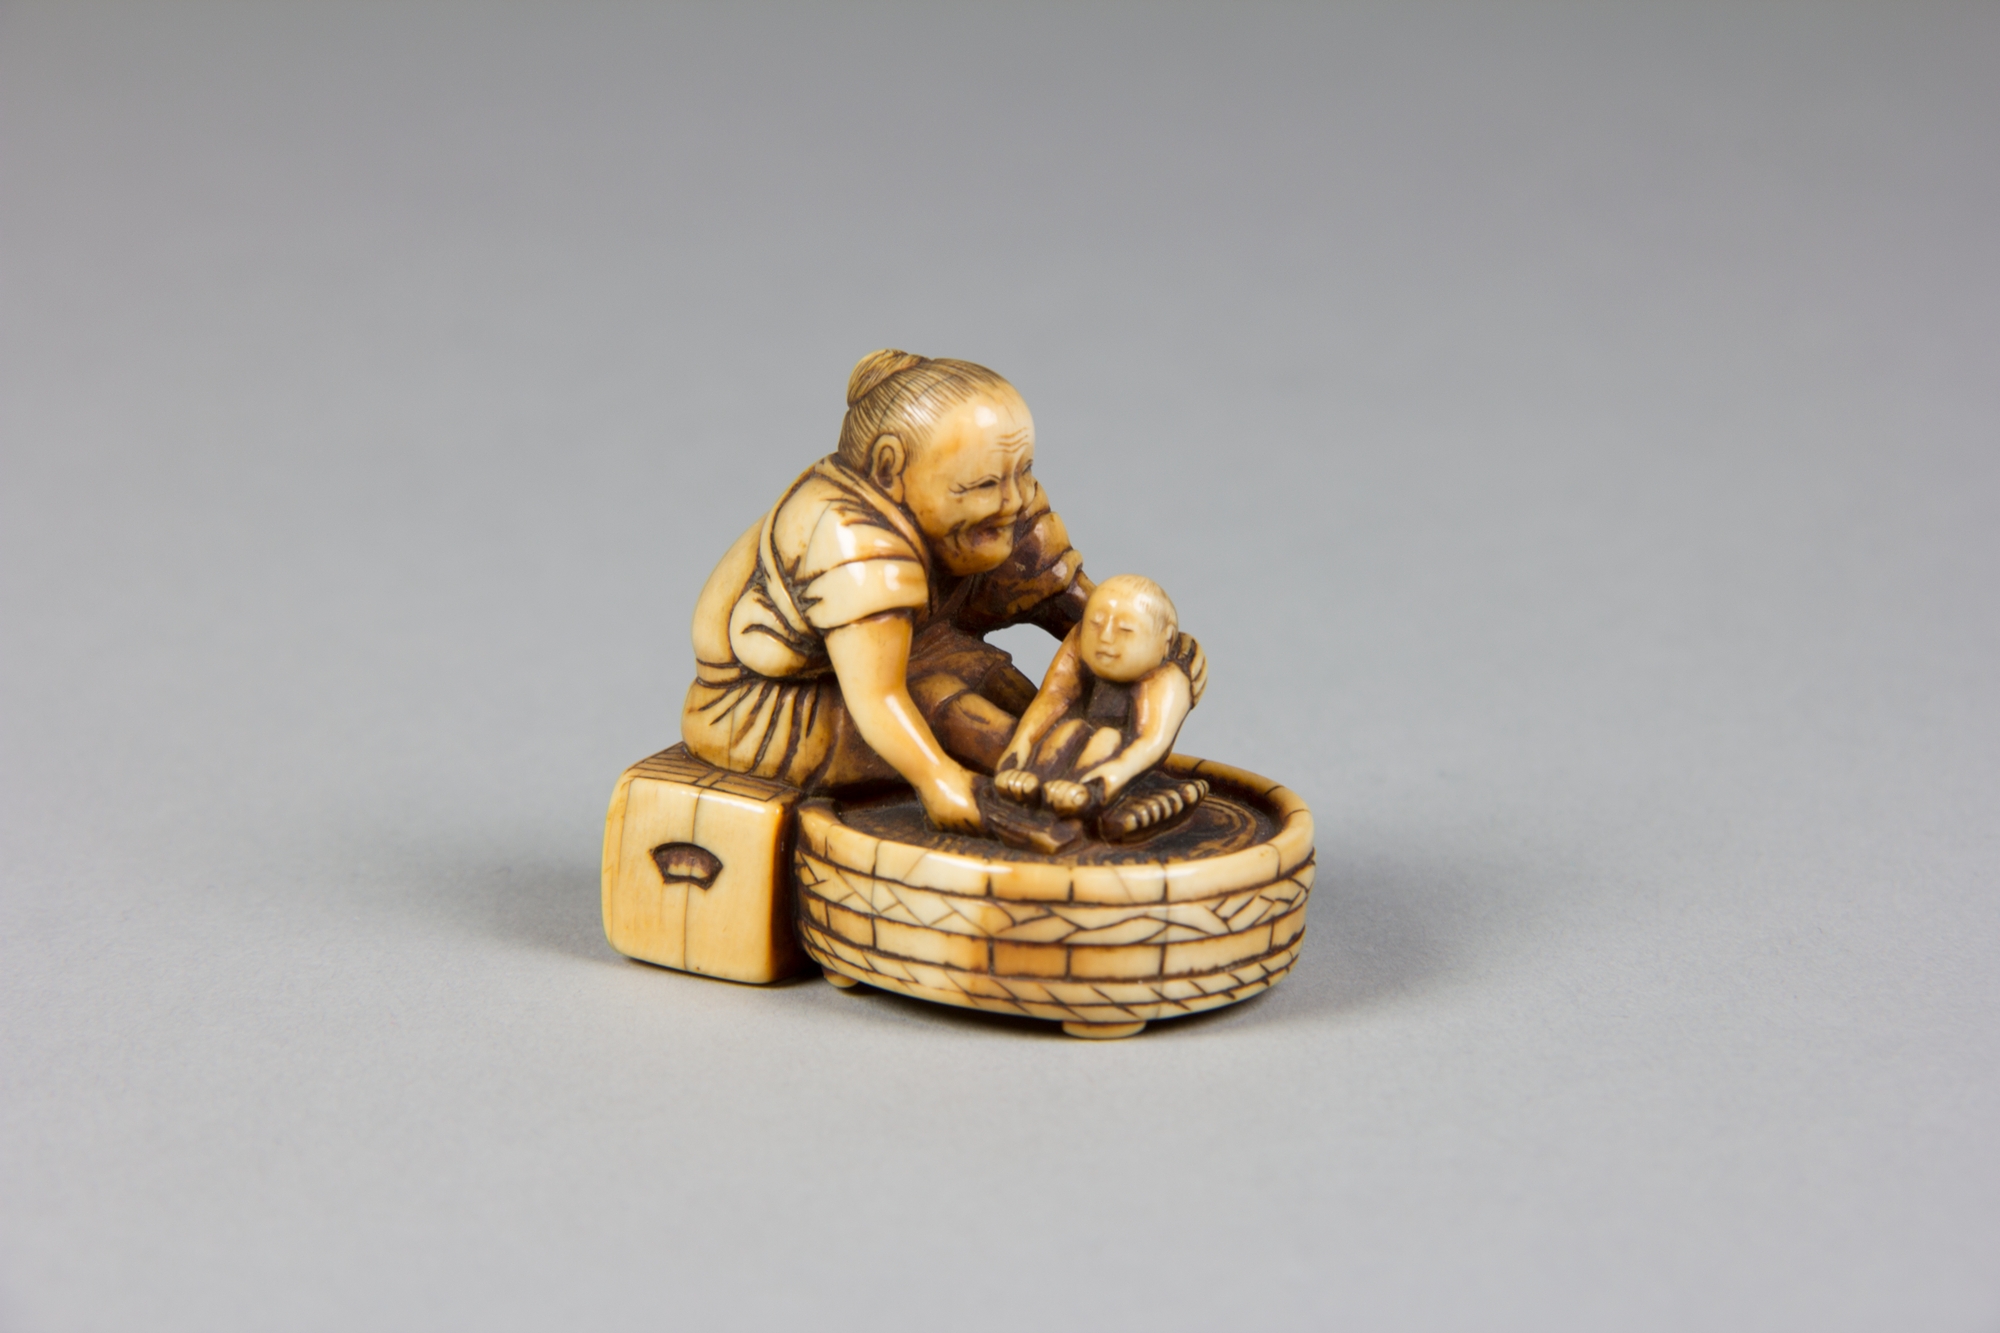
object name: netsuke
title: Netsuke of Old Woman Bathing Child in a Tub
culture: japanese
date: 1701-1900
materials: ivory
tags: children,women,bathing